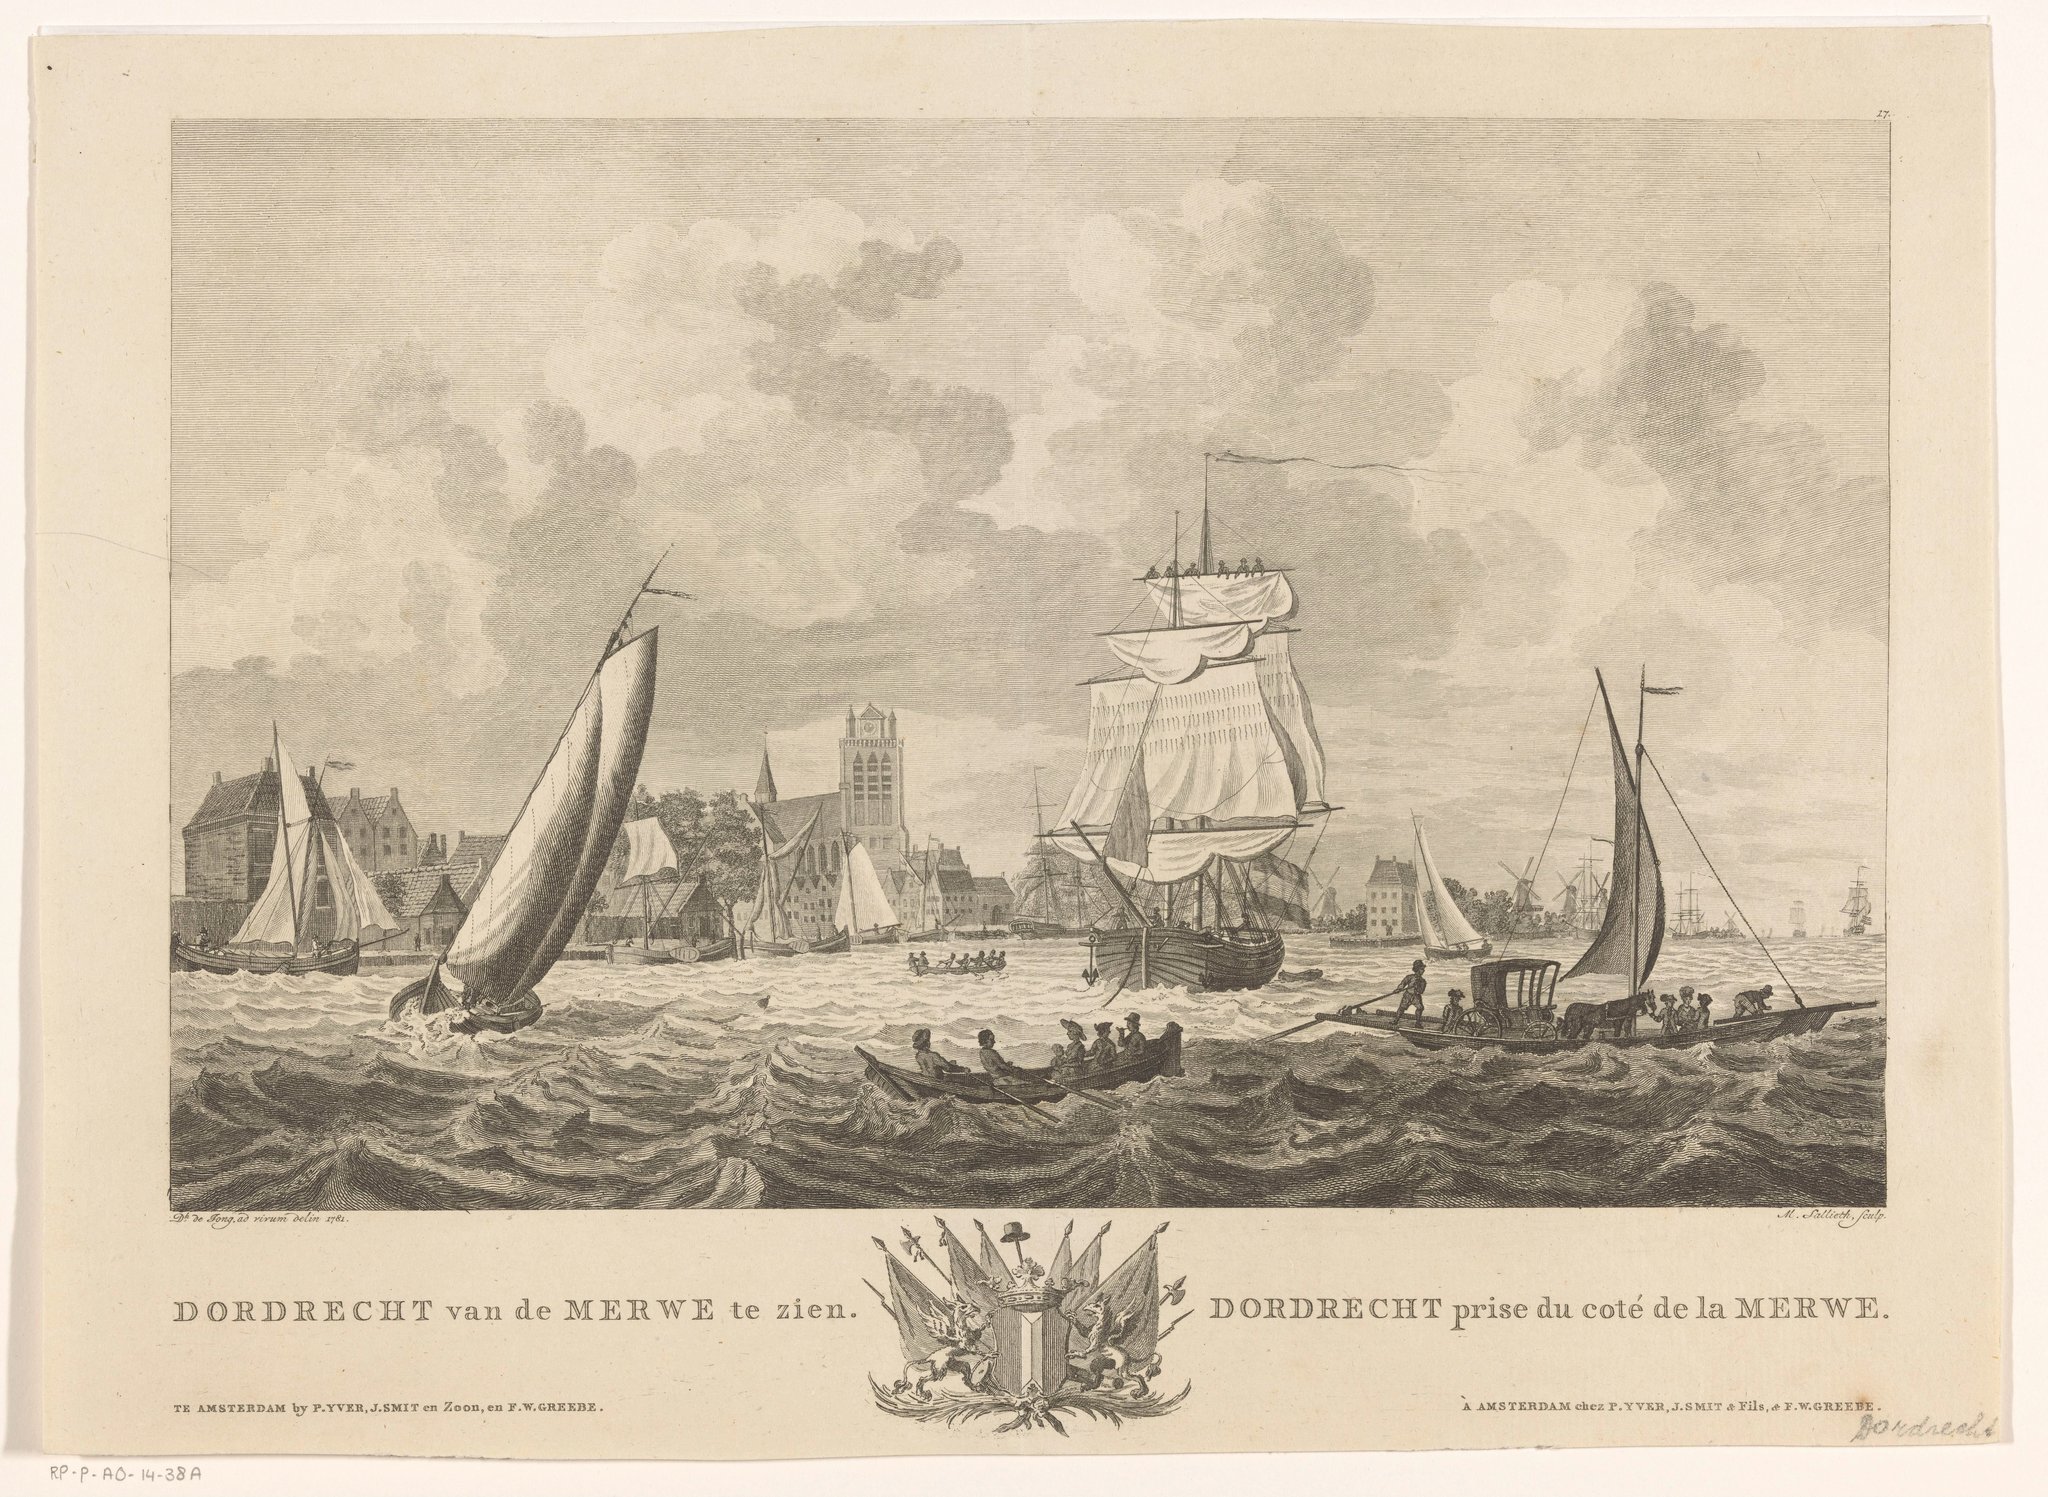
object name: print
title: Gezicht op Dordrecht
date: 1781-1787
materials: paper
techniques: engraving, etching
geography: amsterdam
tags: coat of arms (as symbol of the state, etc.) (+ city; municipal), river, church (exterior), ships (in general) - cc - more than one ship, prospect of city, town panorama, silhouette of city, dordrecht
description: Latere staat ook gebruikt in: Aa, Cornelis van der. Atlas van de zeehavens der Bataafsche Republiek. Met derzelver beschrijvingen in XXXI kunstplaaten / Atlas van de zeehavens der Bataafsche Republiek, die van Batavia en Onrust. Mitsgaders de afbeeldingen van de haringvisscherij en de walvischvangst (…). Amsterdam: Evert Maaskamp, 1805.